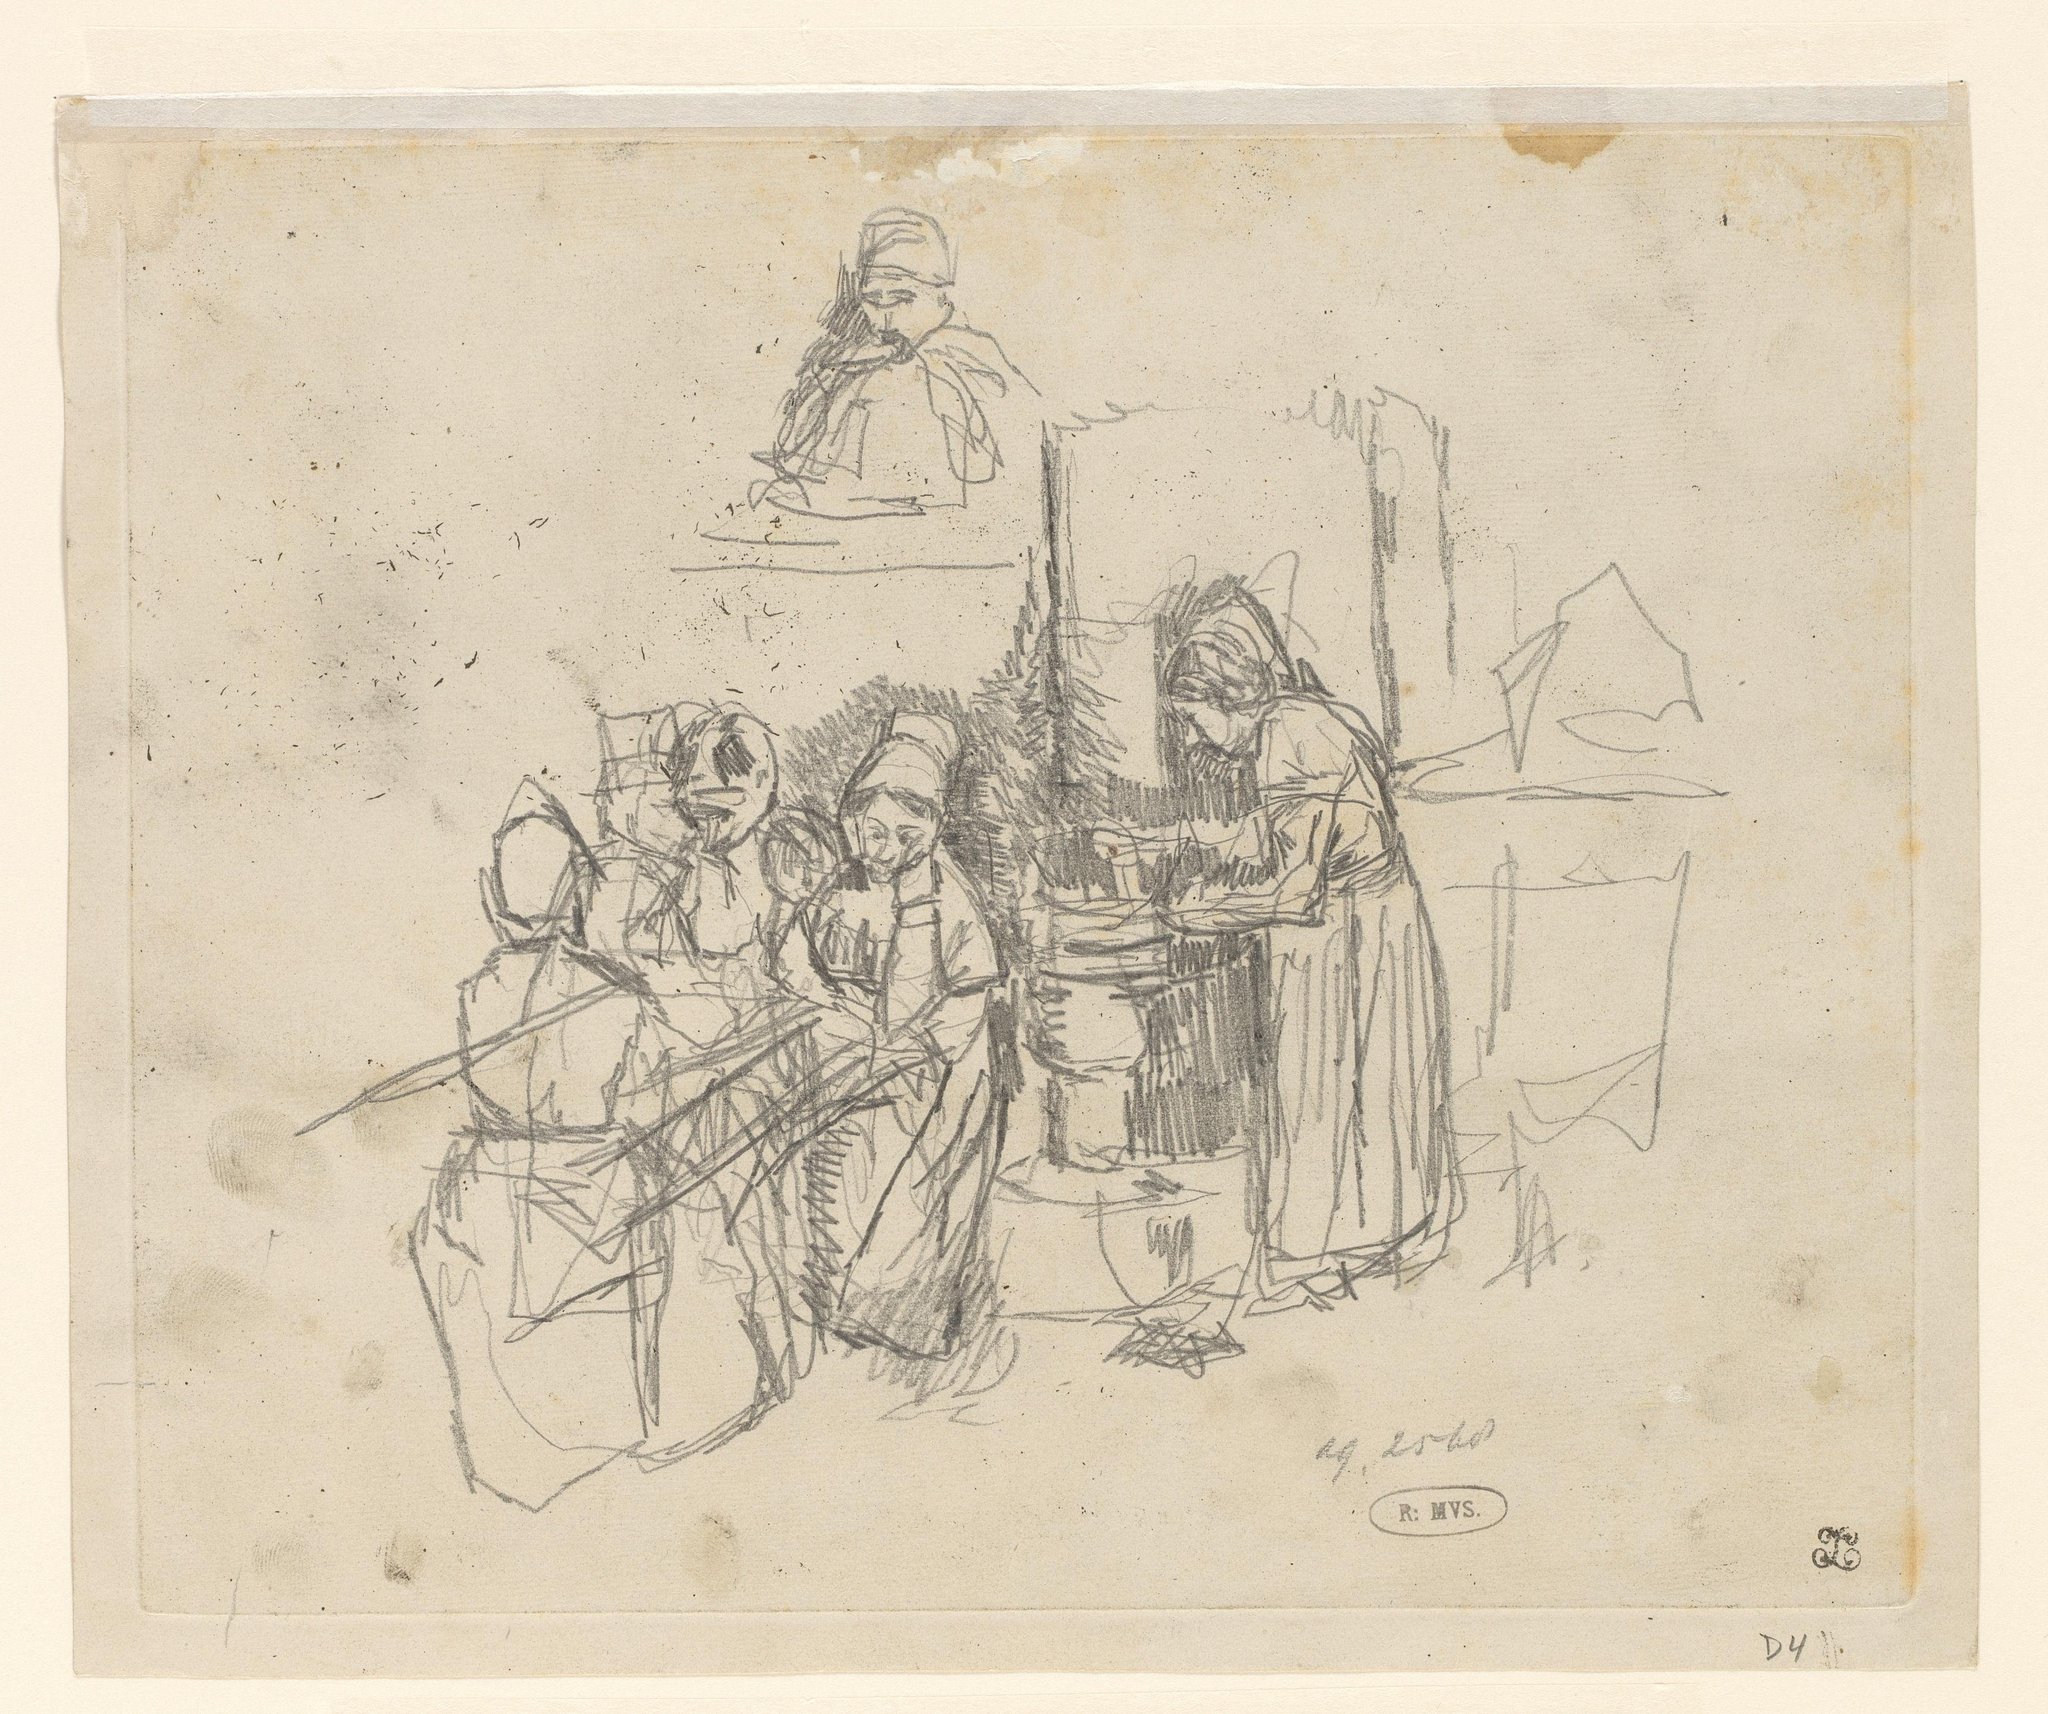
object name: print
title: Straat met kantwerksters aan het werk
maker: henri de braekeleer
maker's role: draughtsman, print maker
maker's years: 1840-1888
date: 1850-1879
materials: paper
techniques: etching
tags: adult woman, adult man, child, lace, street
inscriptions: collector's mark: Lugt 2228, collector's mark: Lugt 1485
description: Straat met kantwerksters aan het werk, spelende kinderen en twee mannen. Op verso een potloodschets van een tafereel van vrouwen aan het werk.